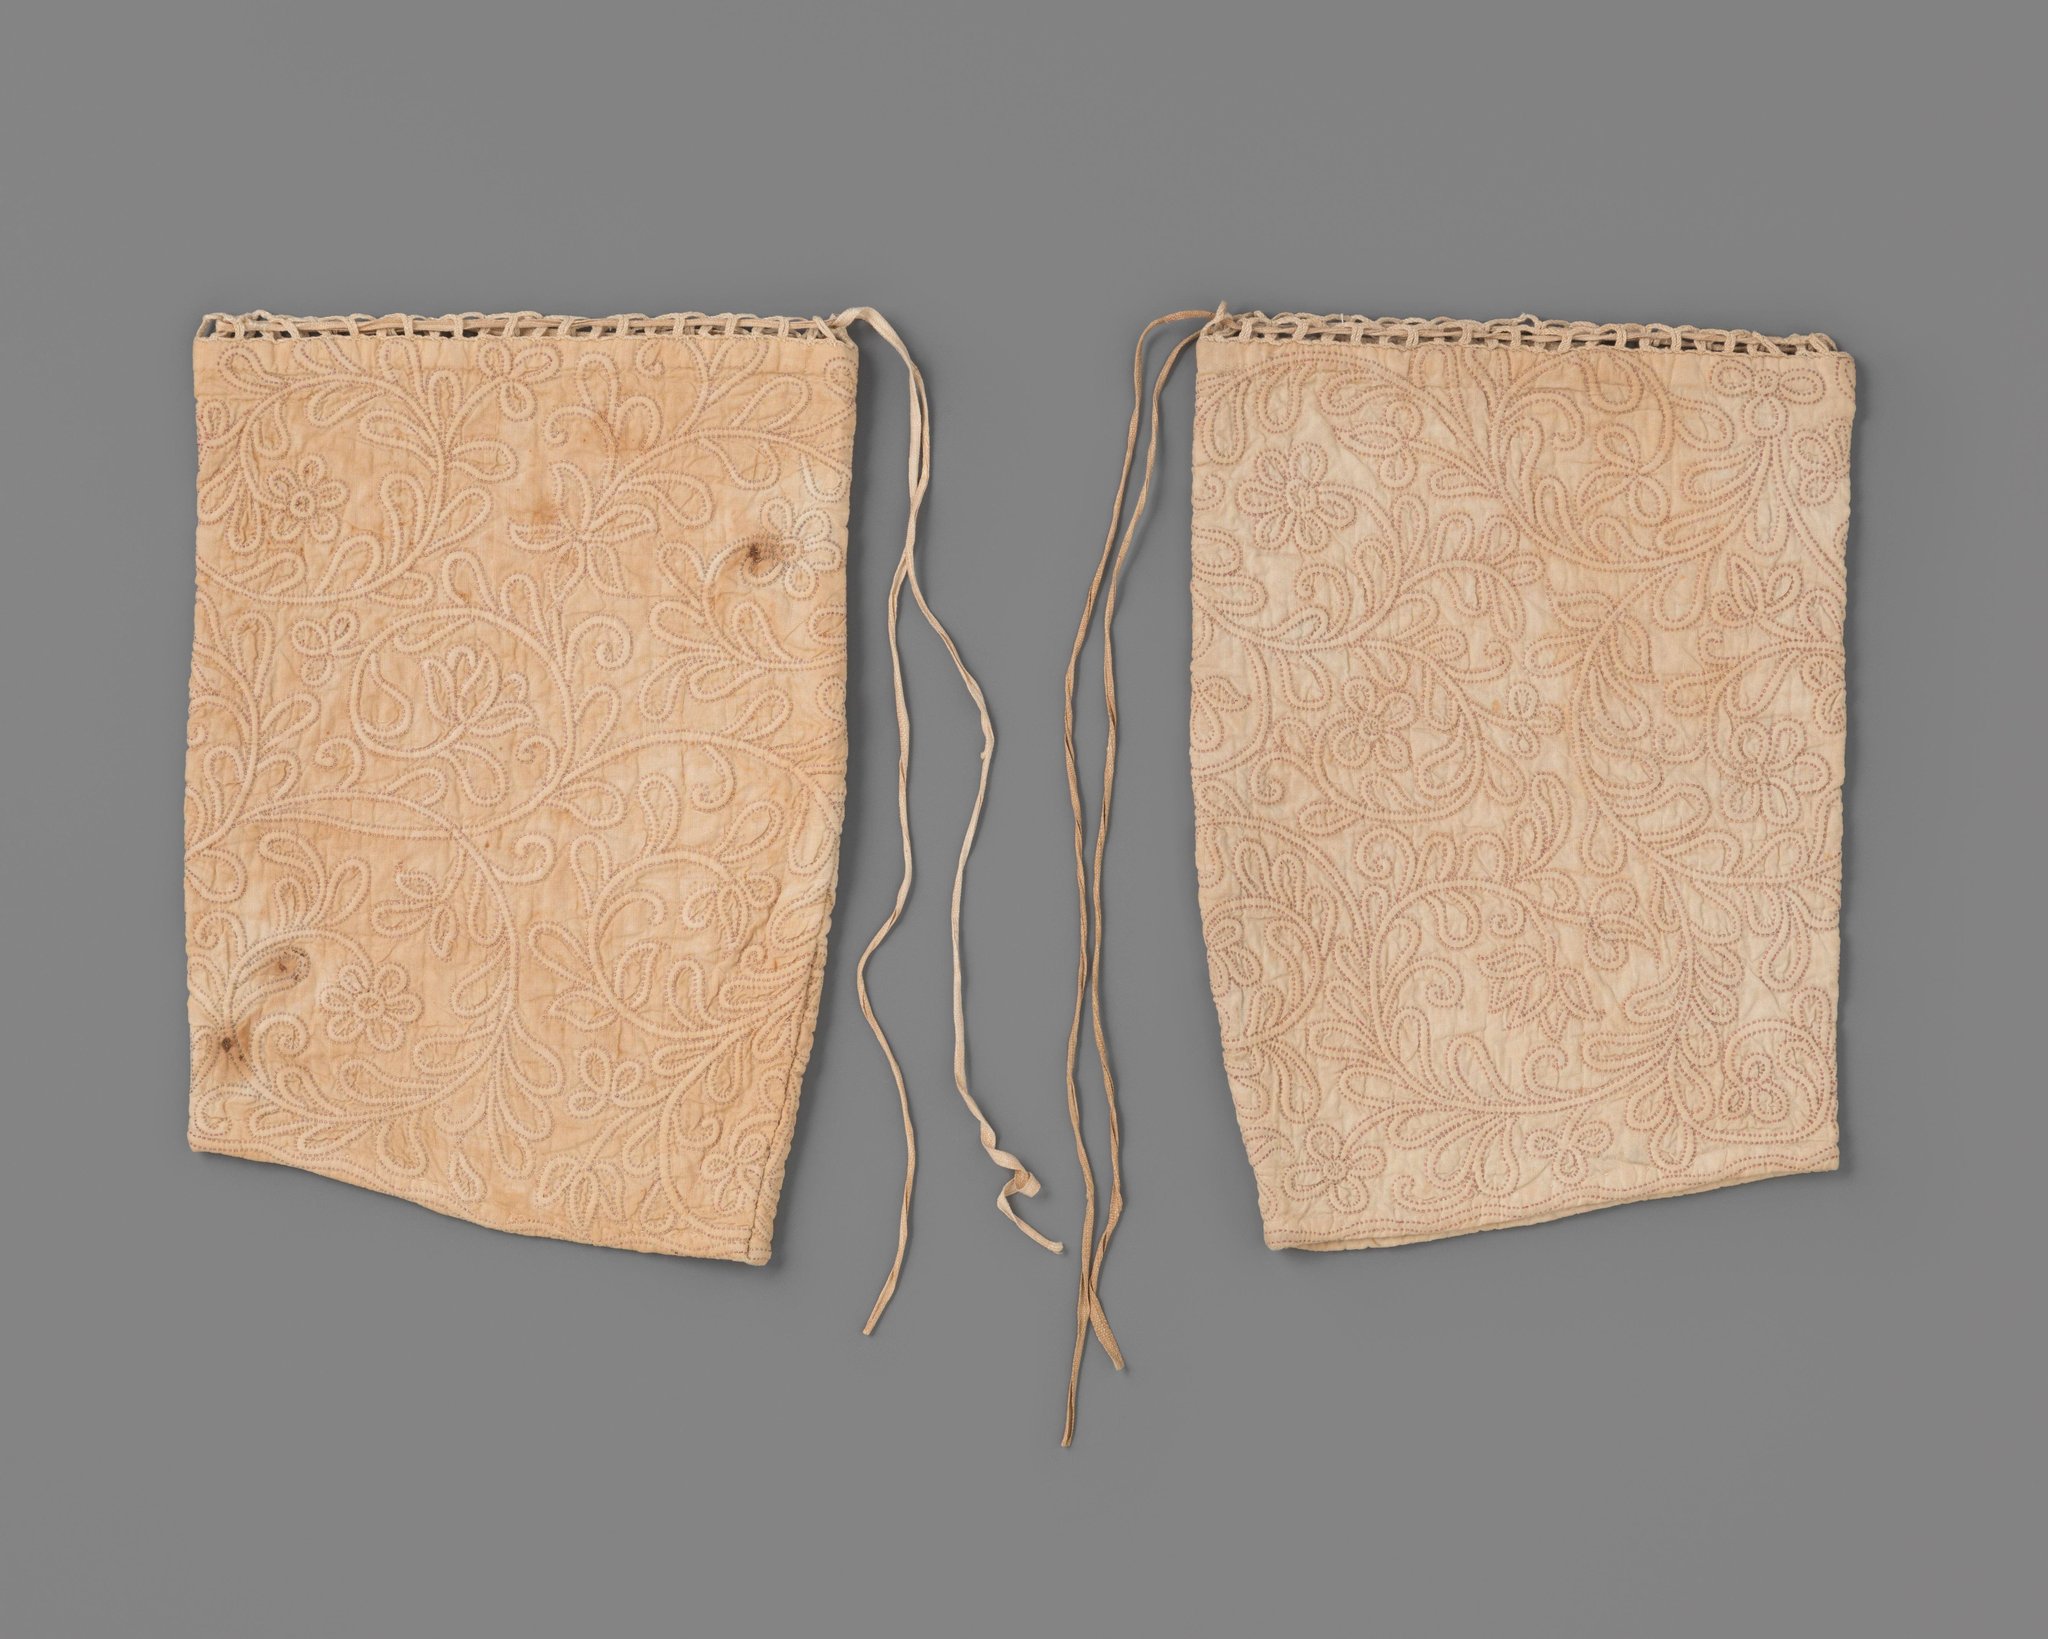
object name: womenswear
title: Ondermouw van batist met bloemranken in point de Marseille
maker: Anonymous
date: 1750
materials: textile, linen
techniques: quilted embroidery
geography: netherlands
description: Ondermouw van batist, versierd met bloemranken in point de Marseille.